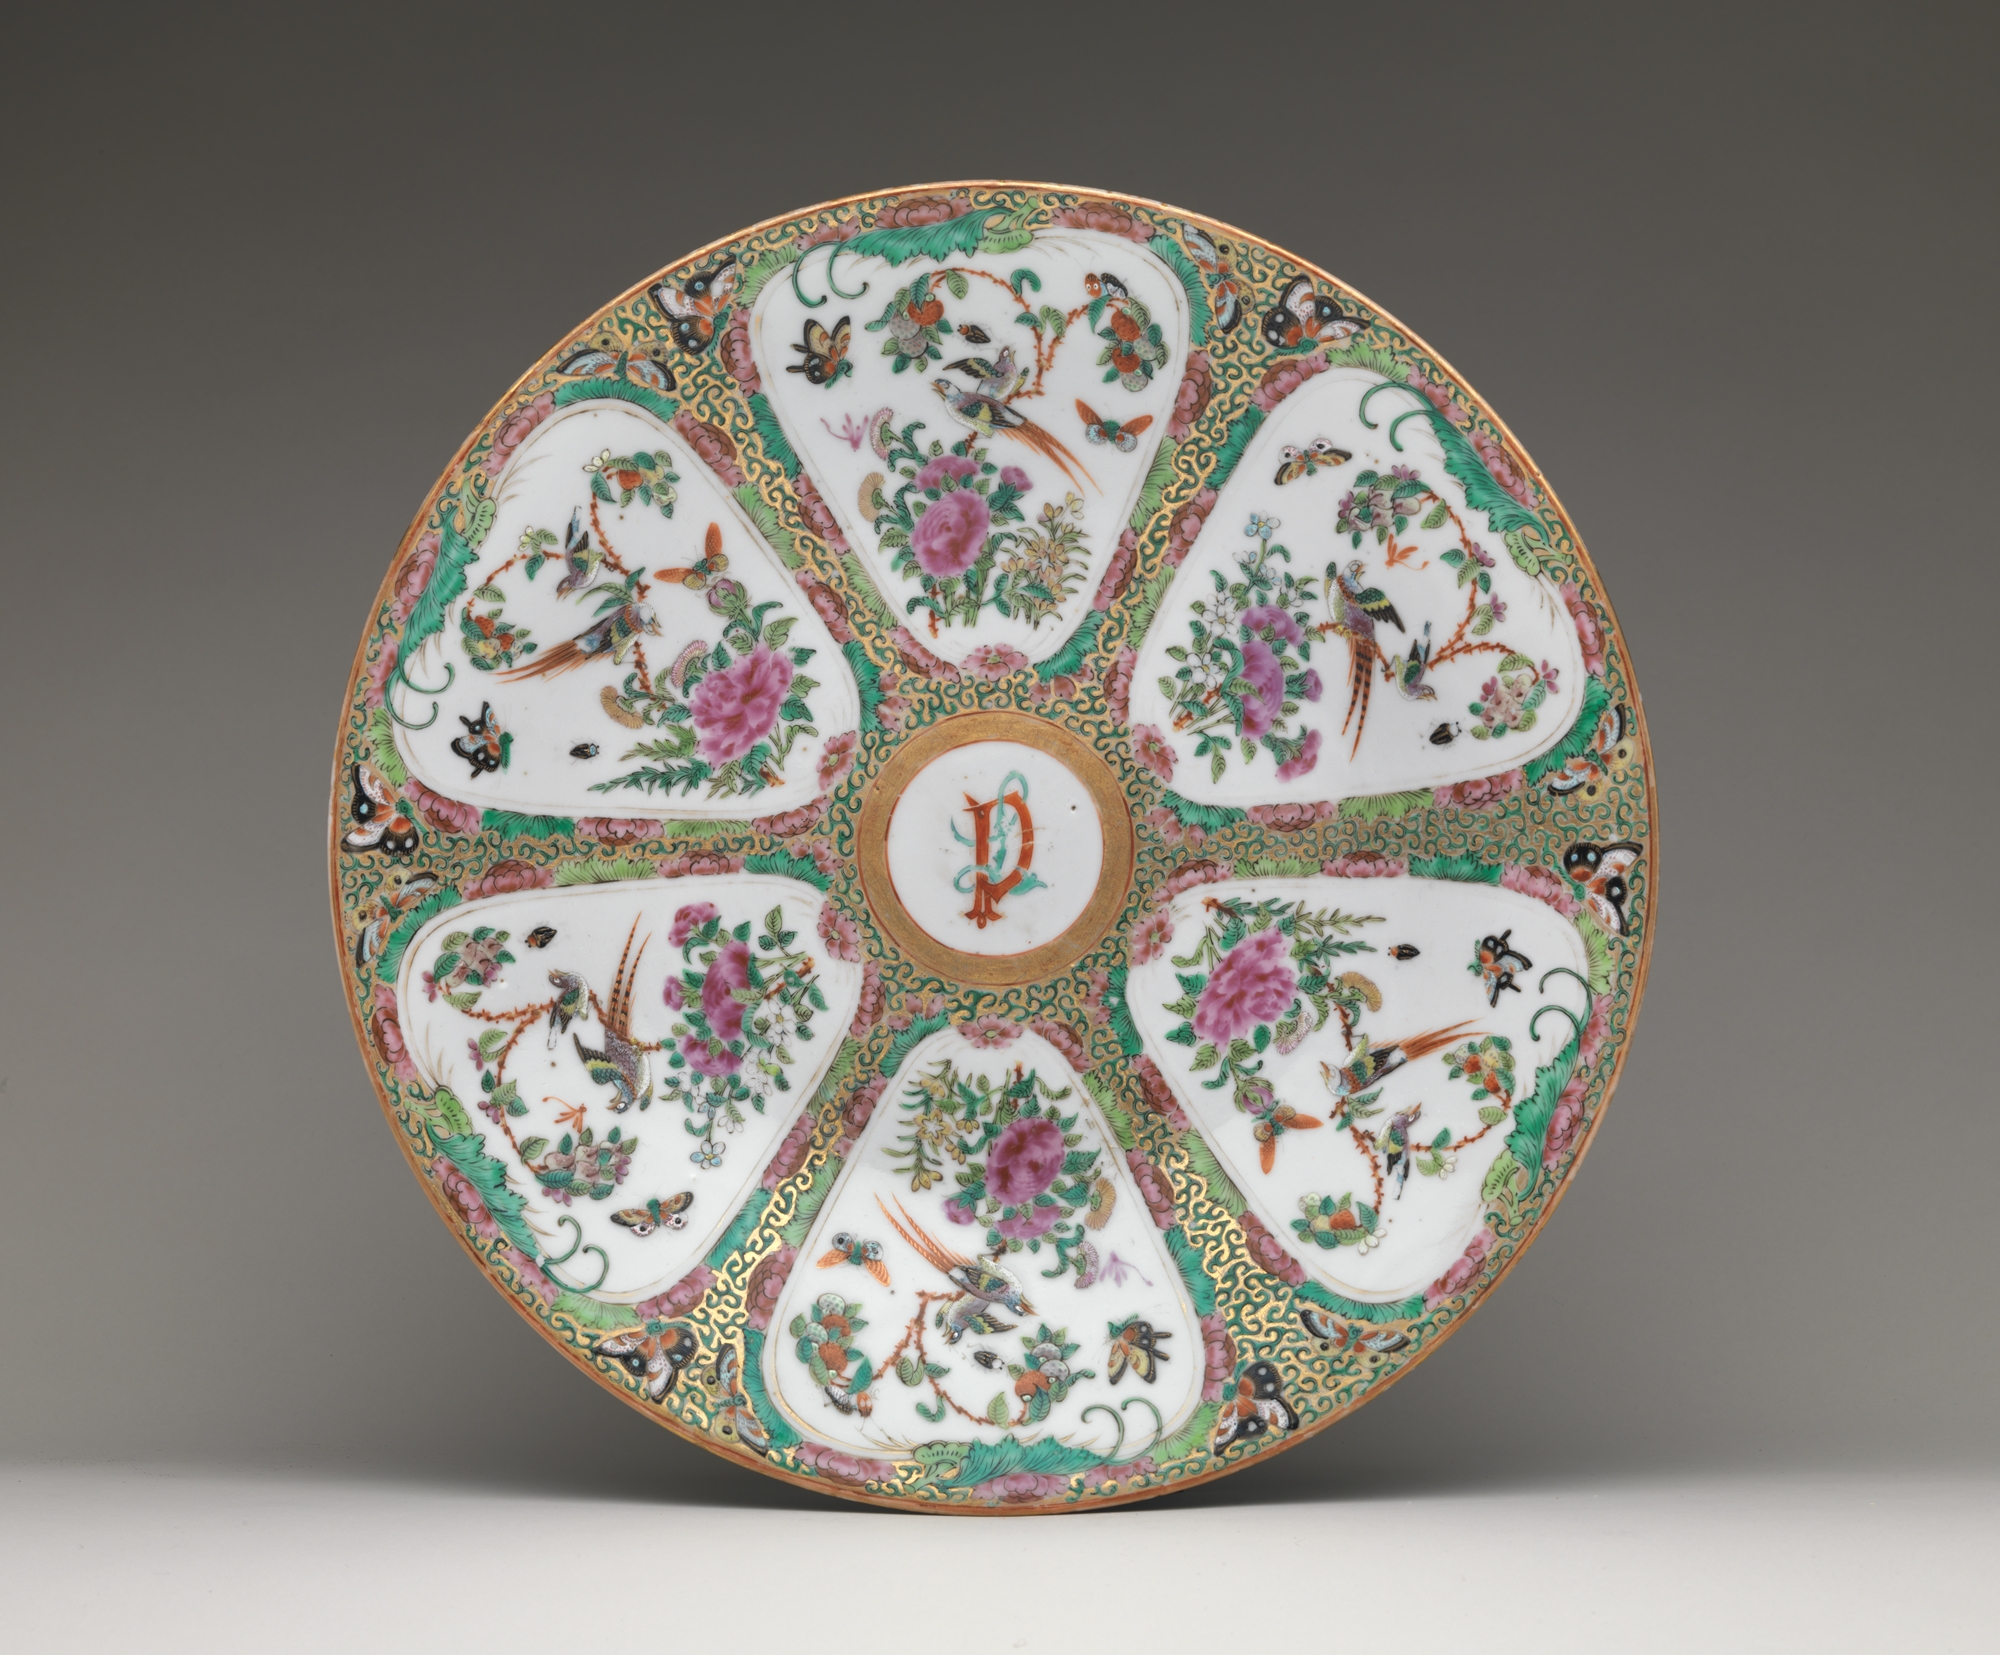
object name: platter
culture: chinese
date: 1860-1866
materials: porcelain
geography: china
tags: birds,butterflies,flowers